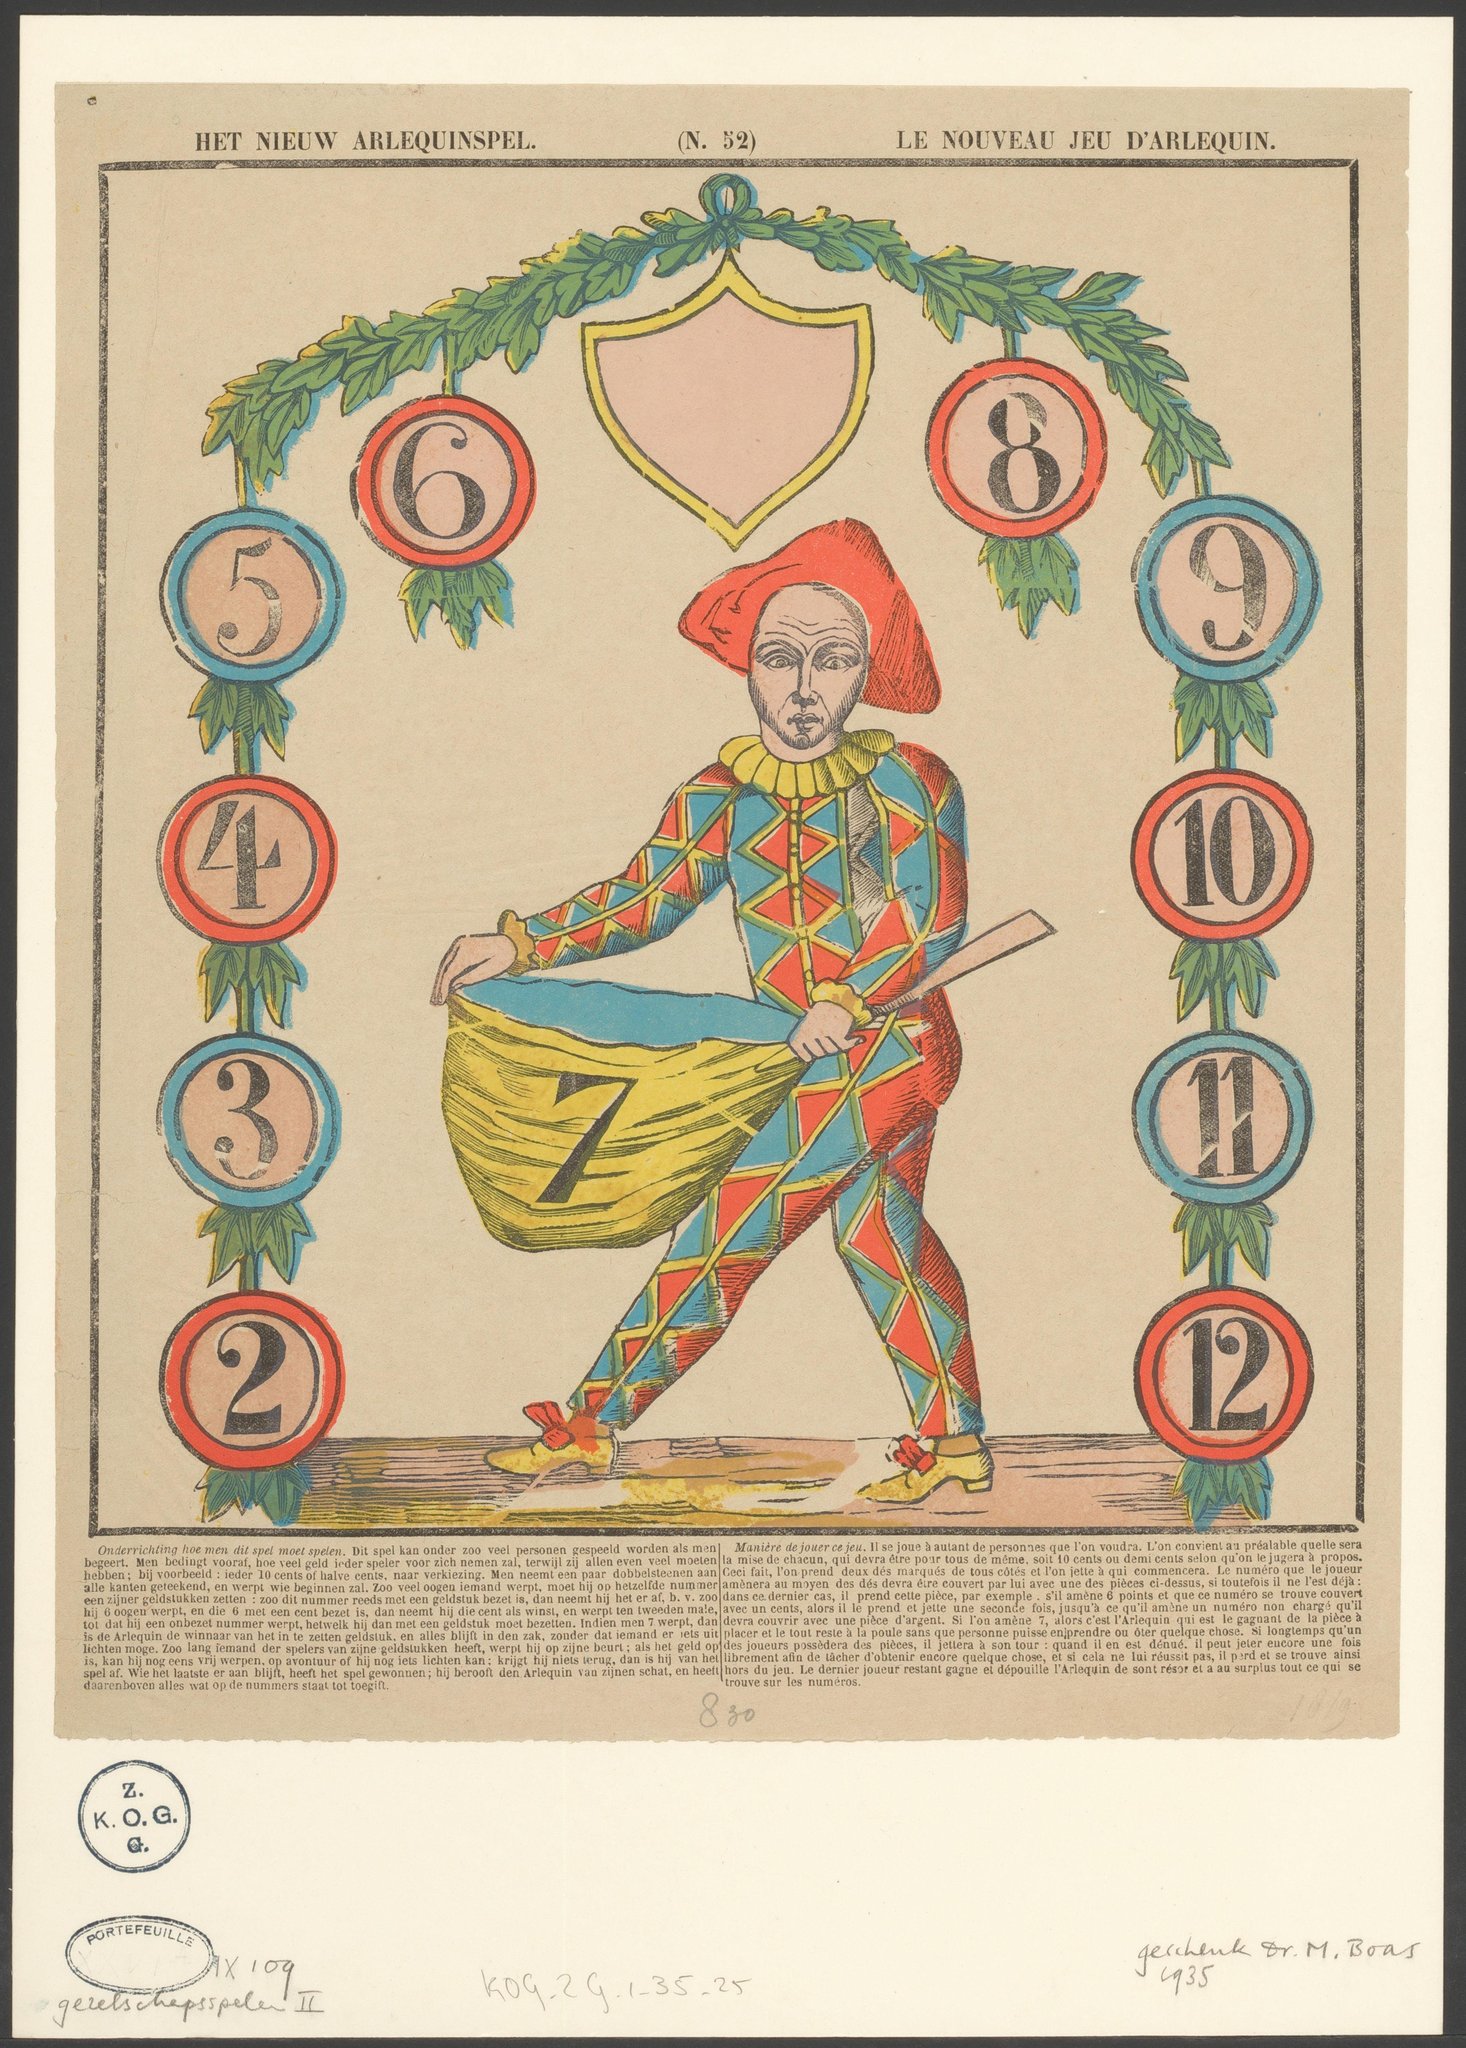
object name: gameboard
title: Speelbord van het Harlequinspel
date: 1830-1840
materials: paper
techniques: hand coloring, letterpress printing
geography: turnhout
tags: court jester, court fool, board-games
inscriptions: stamp, collector's mark: Lugt 1641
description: Bordspel met in het midden van het speelveld een harlekijn die in zijn handen een zak houdt met daarop het cijfer 7. Rondom hem een guirlande waaraan medaillons hangen met de cijfers 2 tot en met 12. Bovenaan in het midden een schild. Onder de voorstelling de spelregels in het Nederlands en in het Frans in twee kolommen. Genummerd midden boven: N. 52. Onderwerpsrubrieken binnen de Atlas Zeden en Gewoonten: Zeden en gewoonten in engeren zin, Spel en vermaak, Gezelschapsspel II, Ganzenbord en dergelijke.